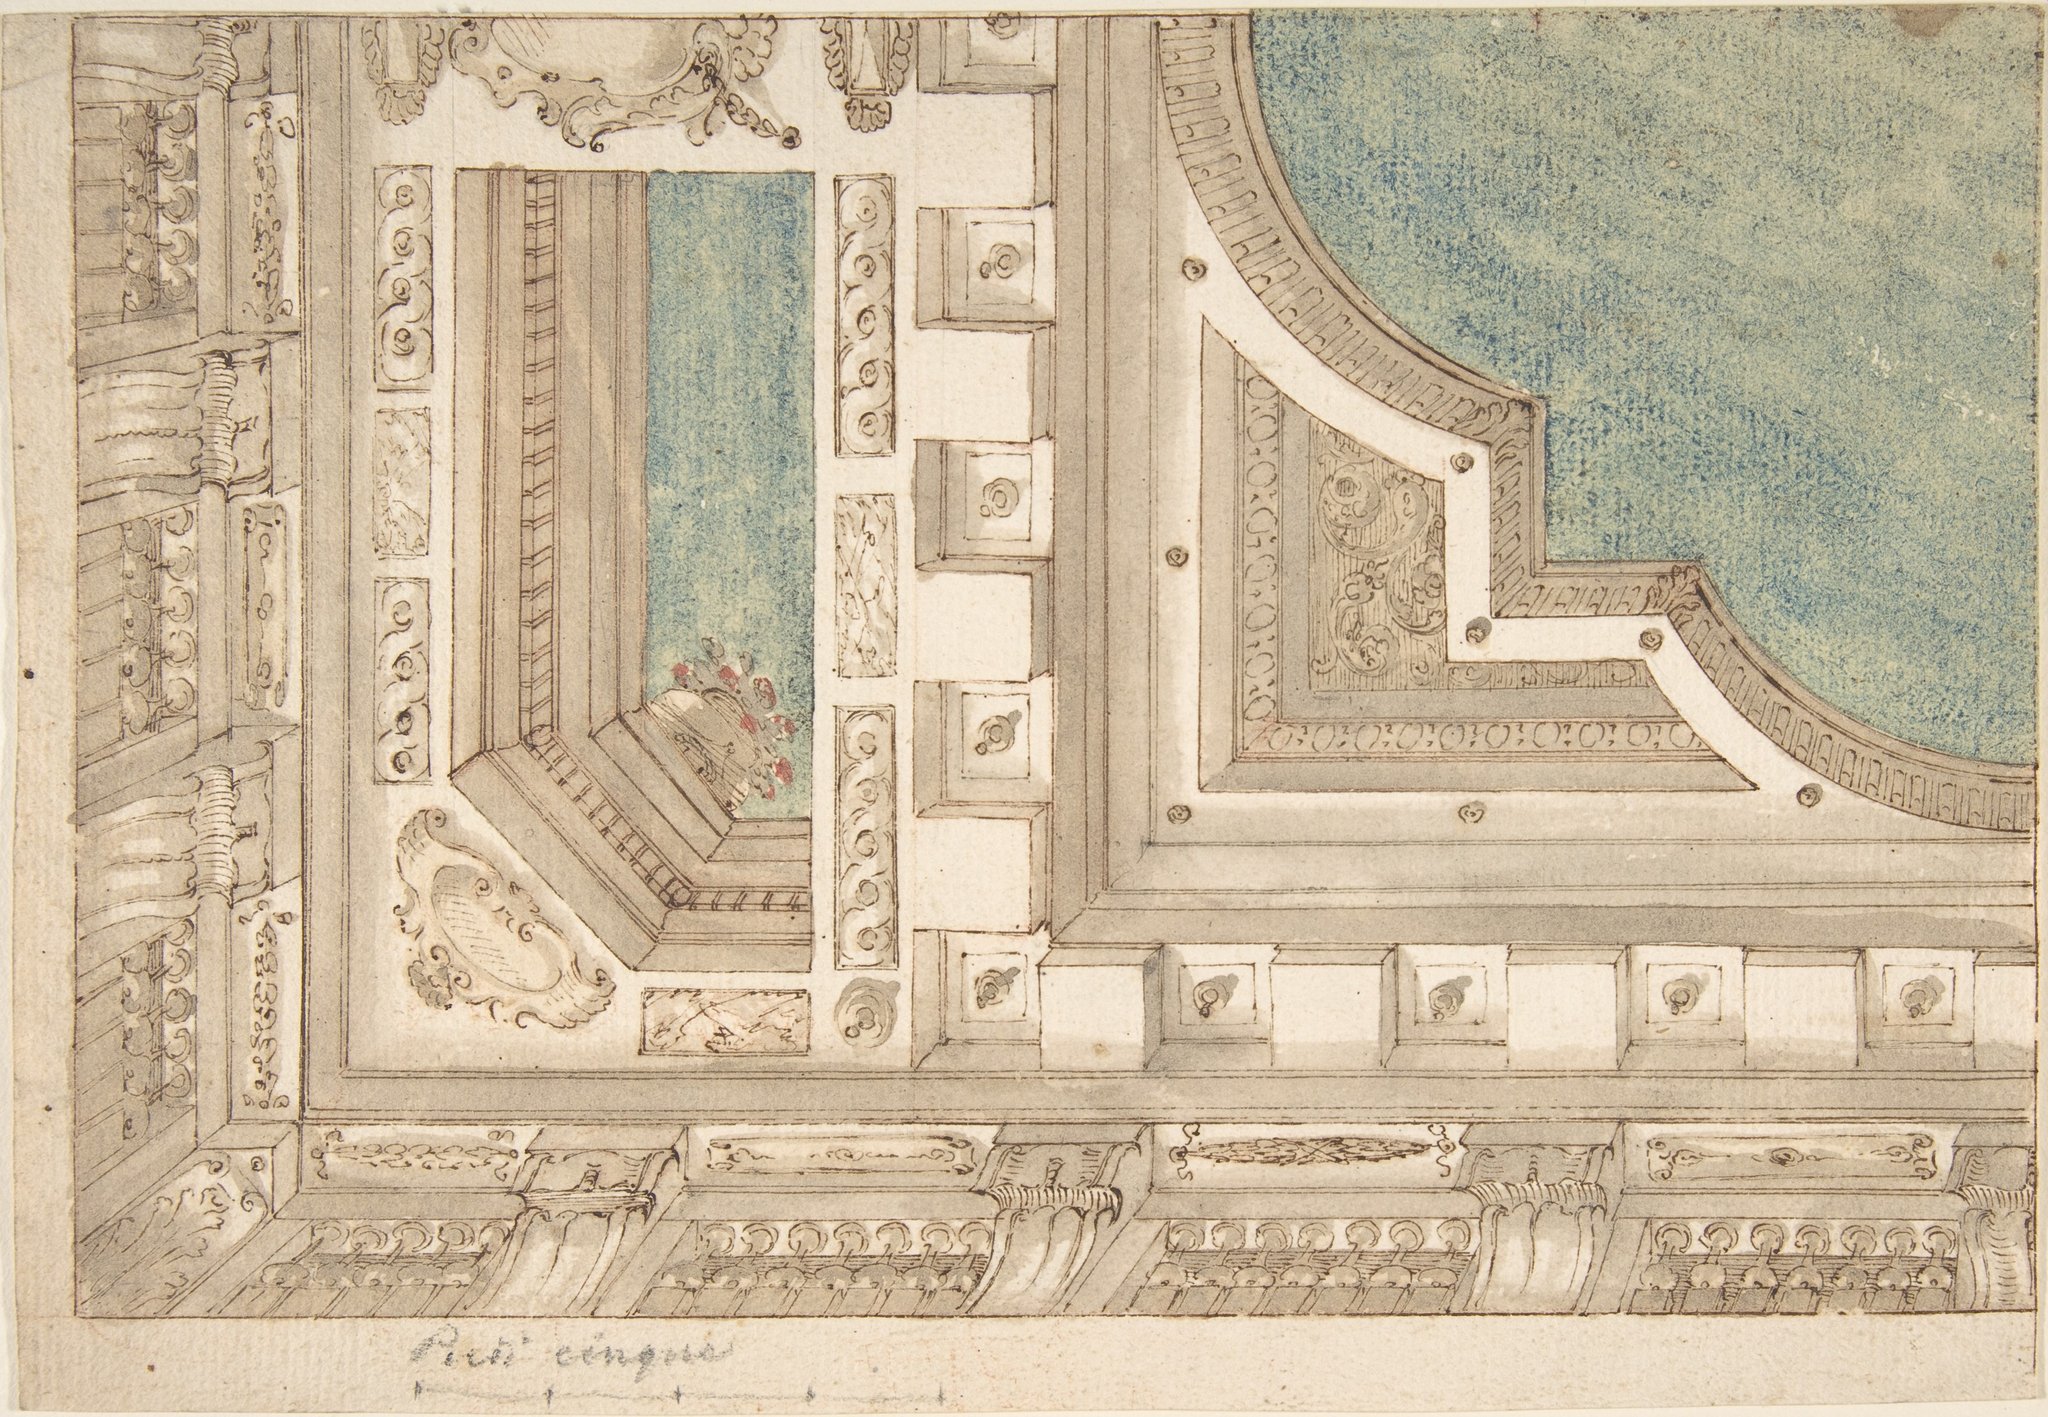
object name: drawing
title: Design for a Ceiling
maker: anonymous, italian, 18th century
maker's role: artist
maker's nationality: italian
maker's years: 1700-1800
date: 1701-1800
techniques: pen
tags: architecture